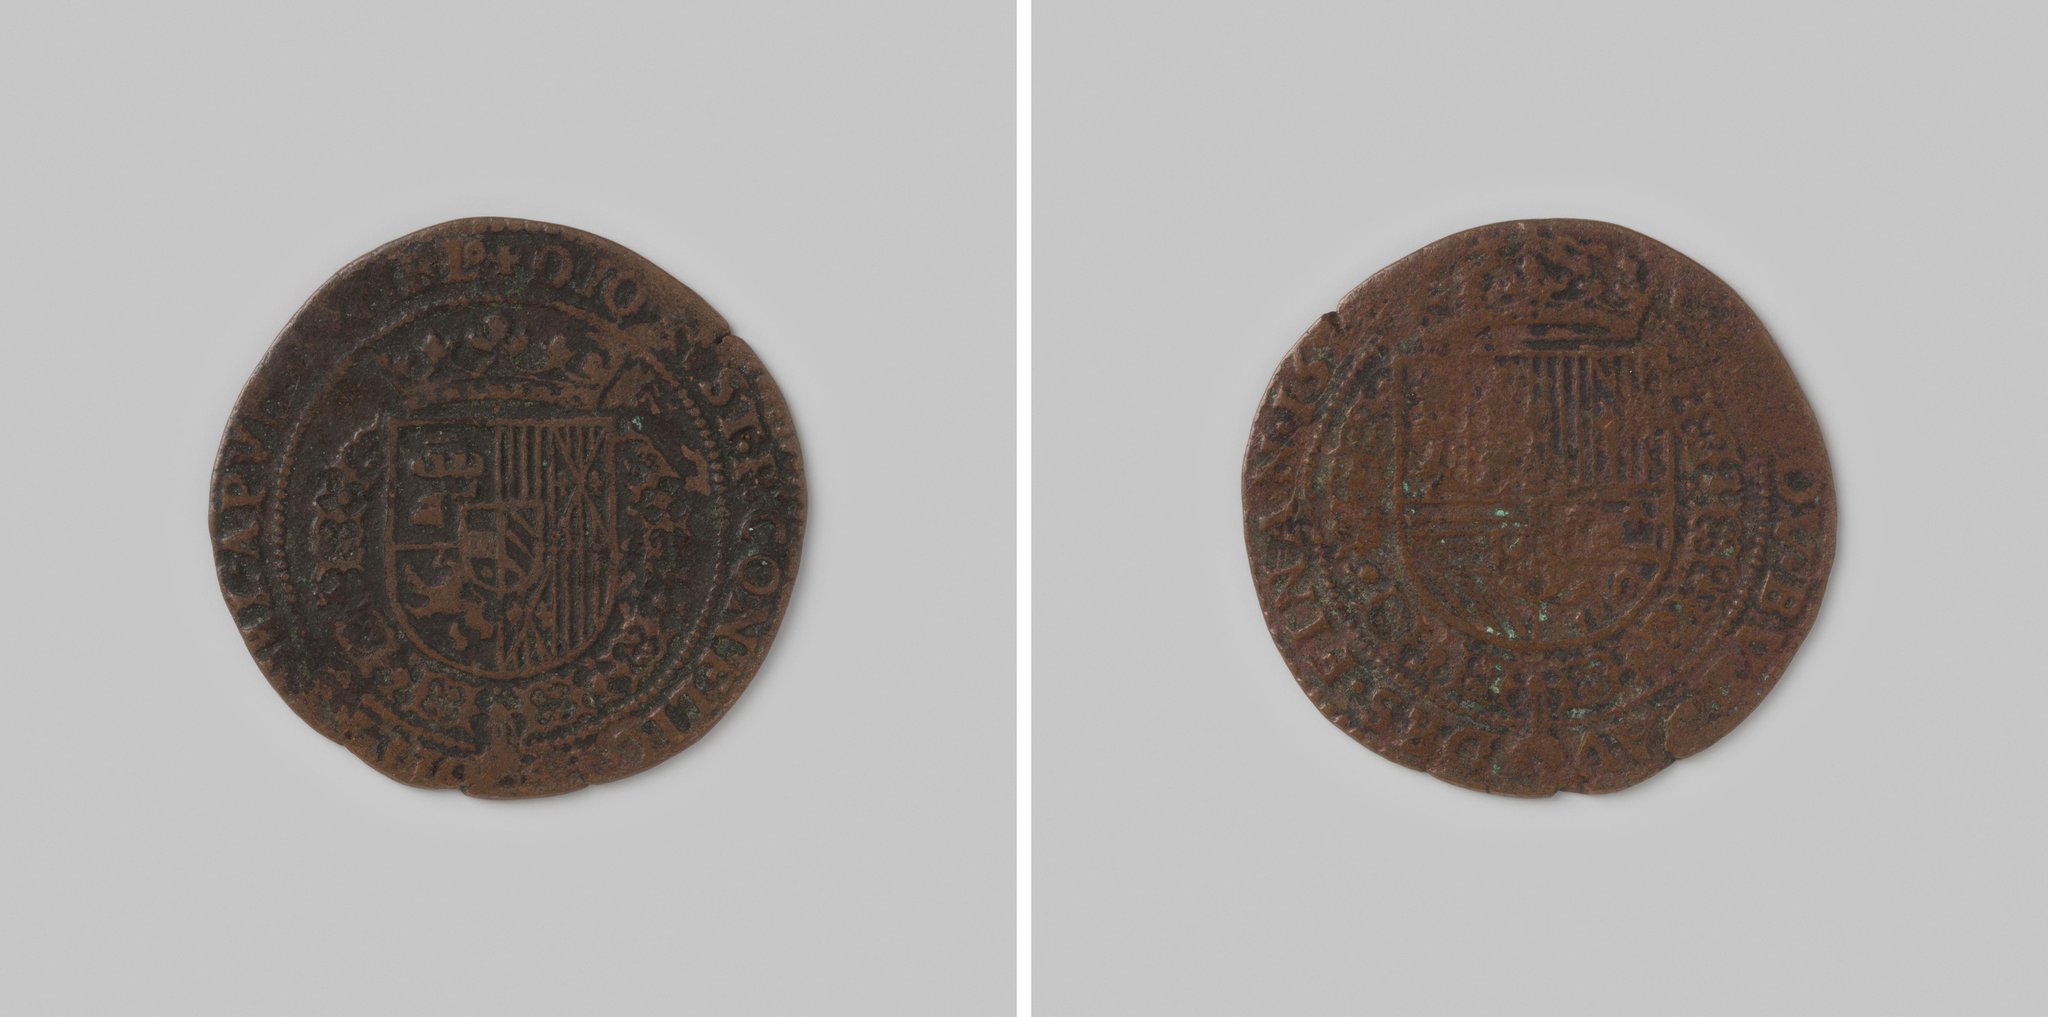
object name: jeton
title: Rekenpenning op de slag bij Gembloux 1578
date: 1578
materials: copper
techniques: striking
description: Koperen penning, op de voorzijde een gekroond Spaans wapenschild omhangen met de keten van het Gulden Vlies, met omschrift, op de keerzijde een gekroond Spaans wapenschild omhangen met de keten van het Gulden Vlies, met omschrift.